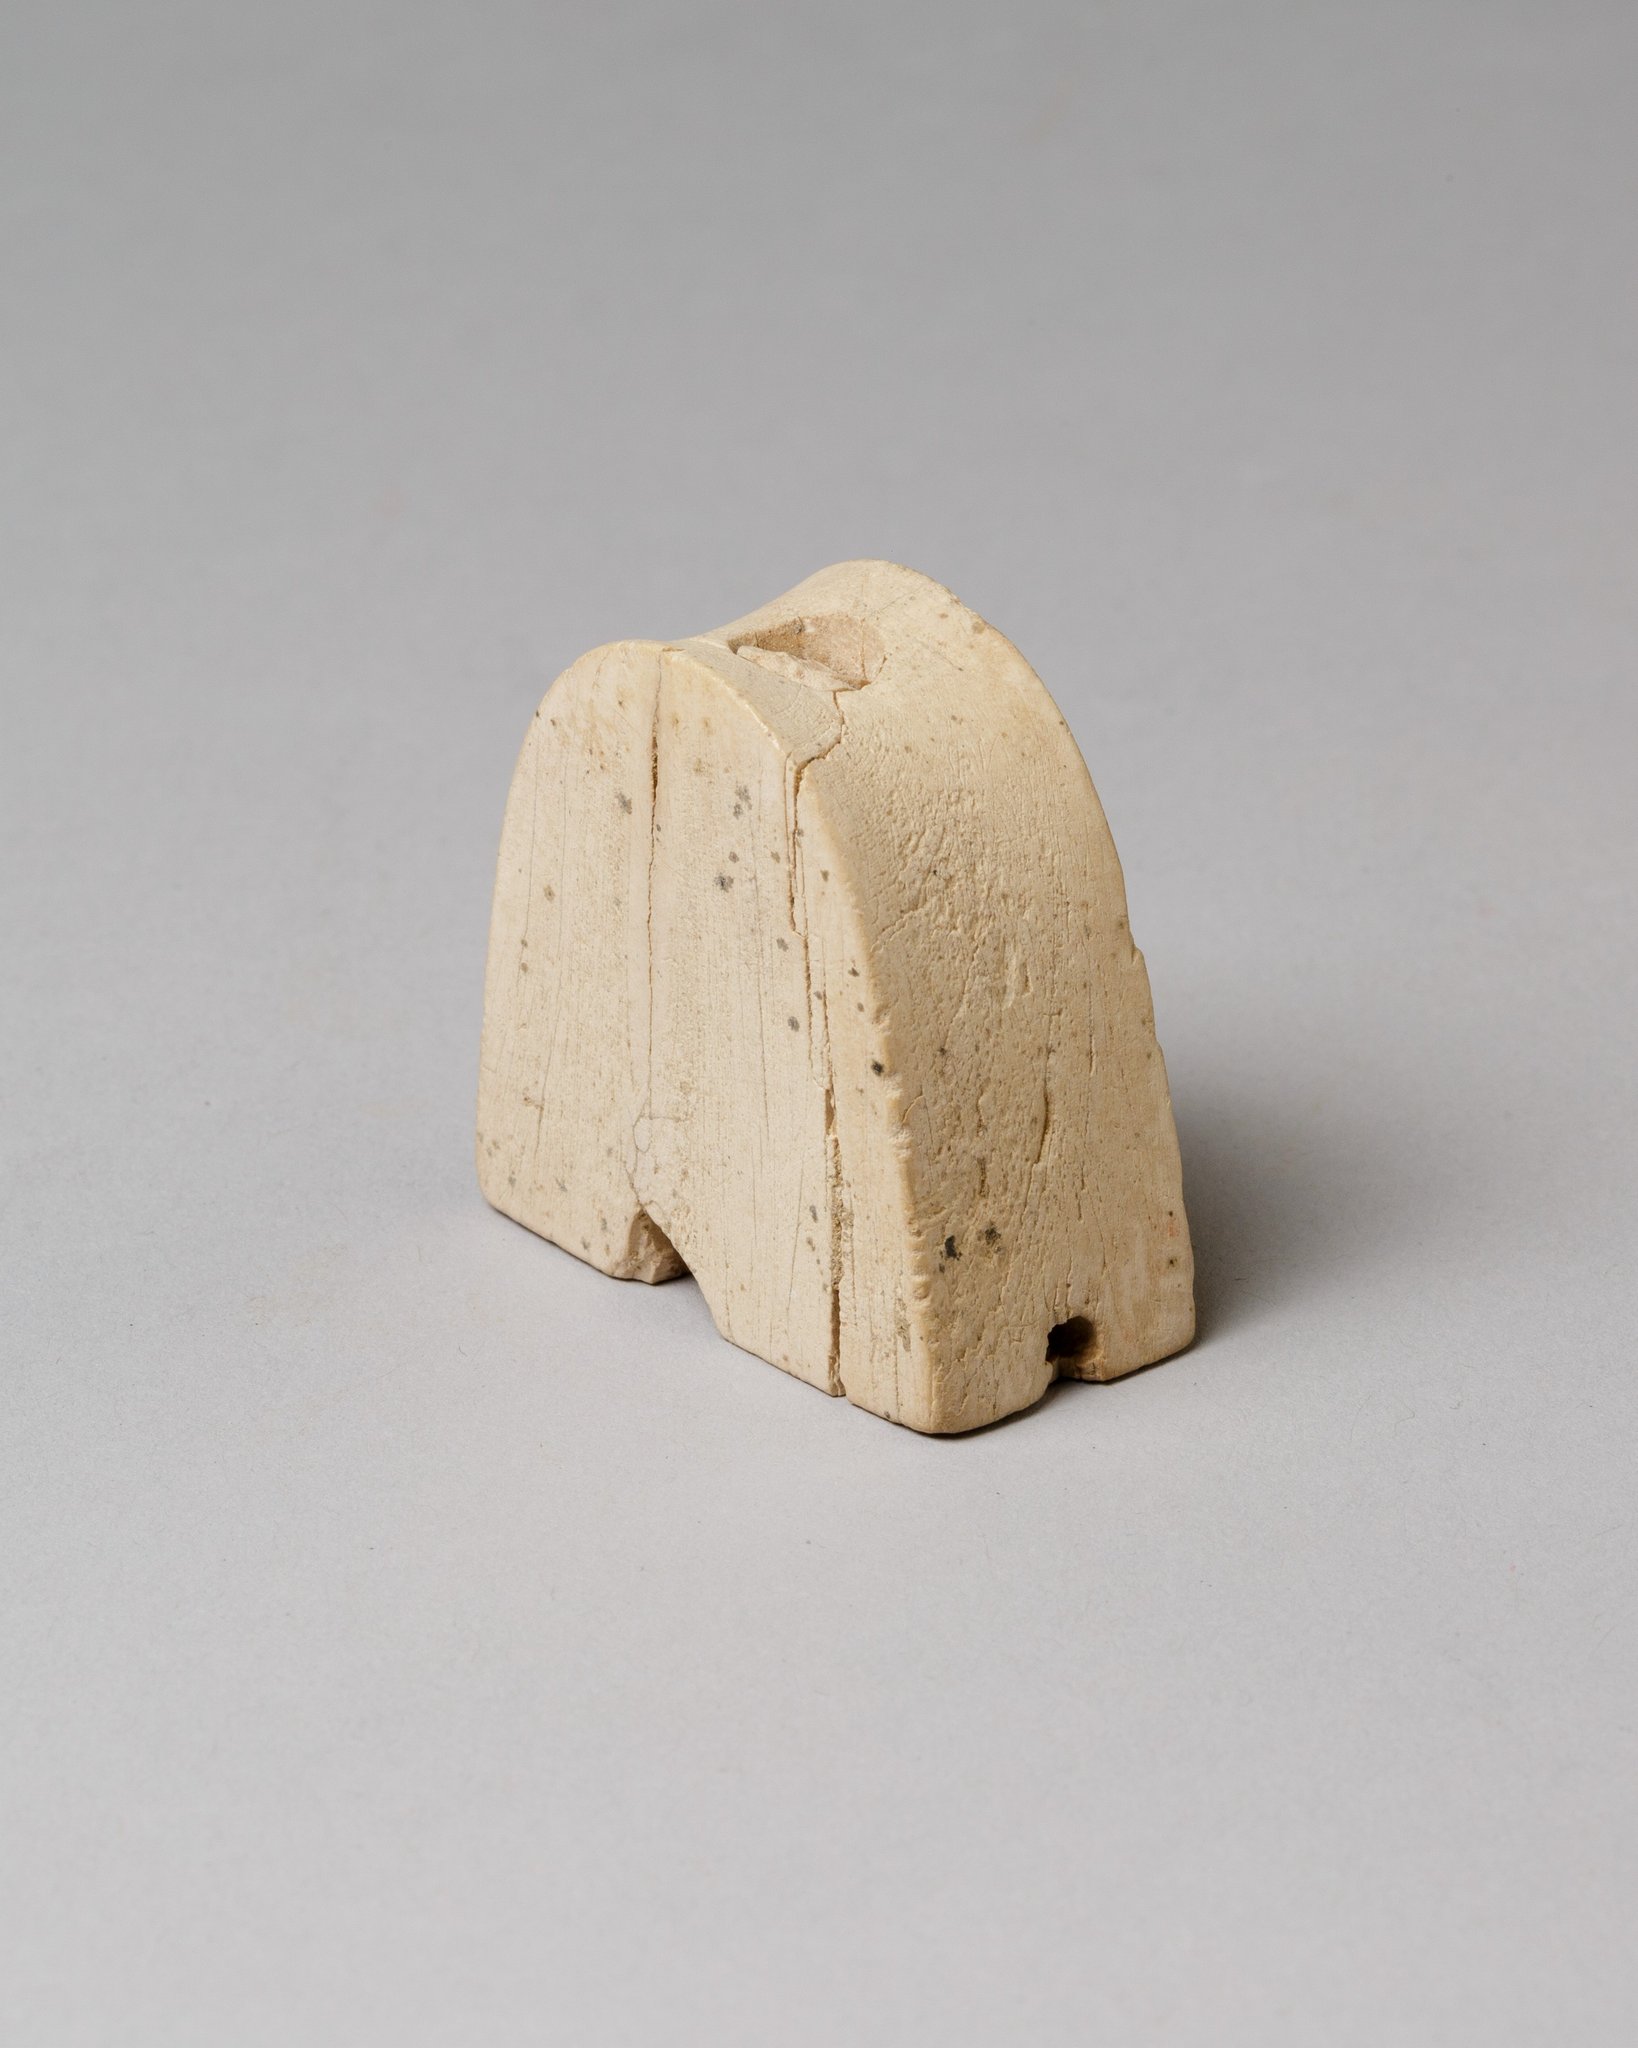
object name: papyrus burnisher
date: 1850-1640 BCE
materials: ivory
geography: egypt